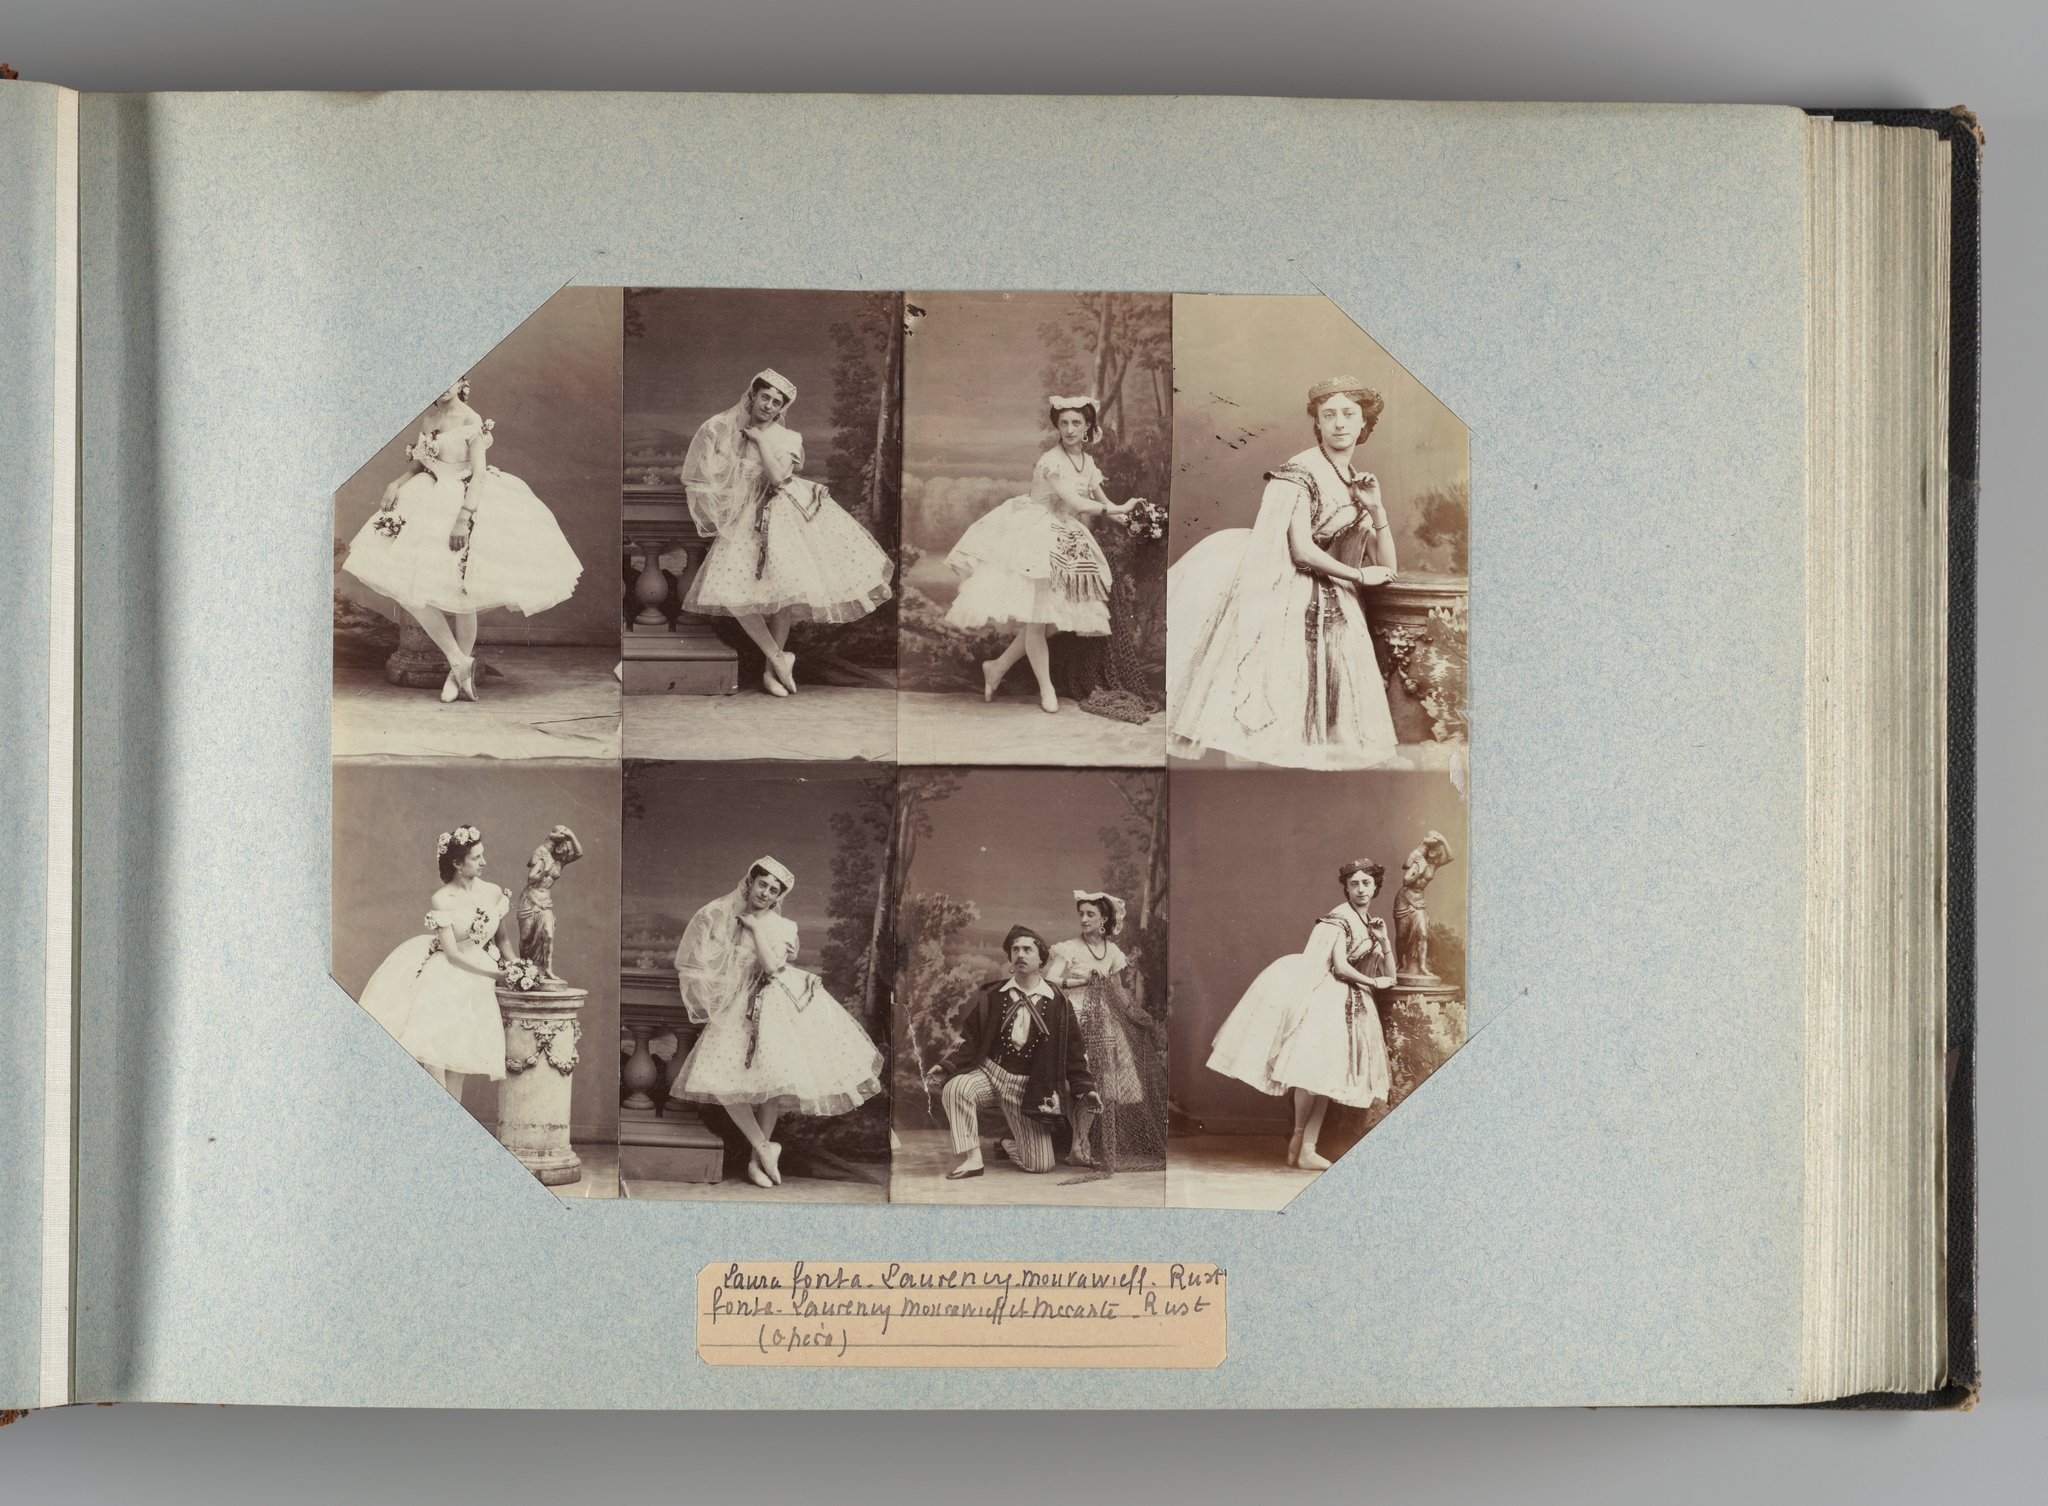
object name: photograph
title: Laura Fonta - Laurency - Mourawieff - Rust - Fonta - Laurency - Mourawieff et Merante - Rust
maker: andré-adolphe-eugène disdéri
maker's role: artist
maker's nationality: french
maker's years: 1819-1889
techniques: albumen silver print, glass negative